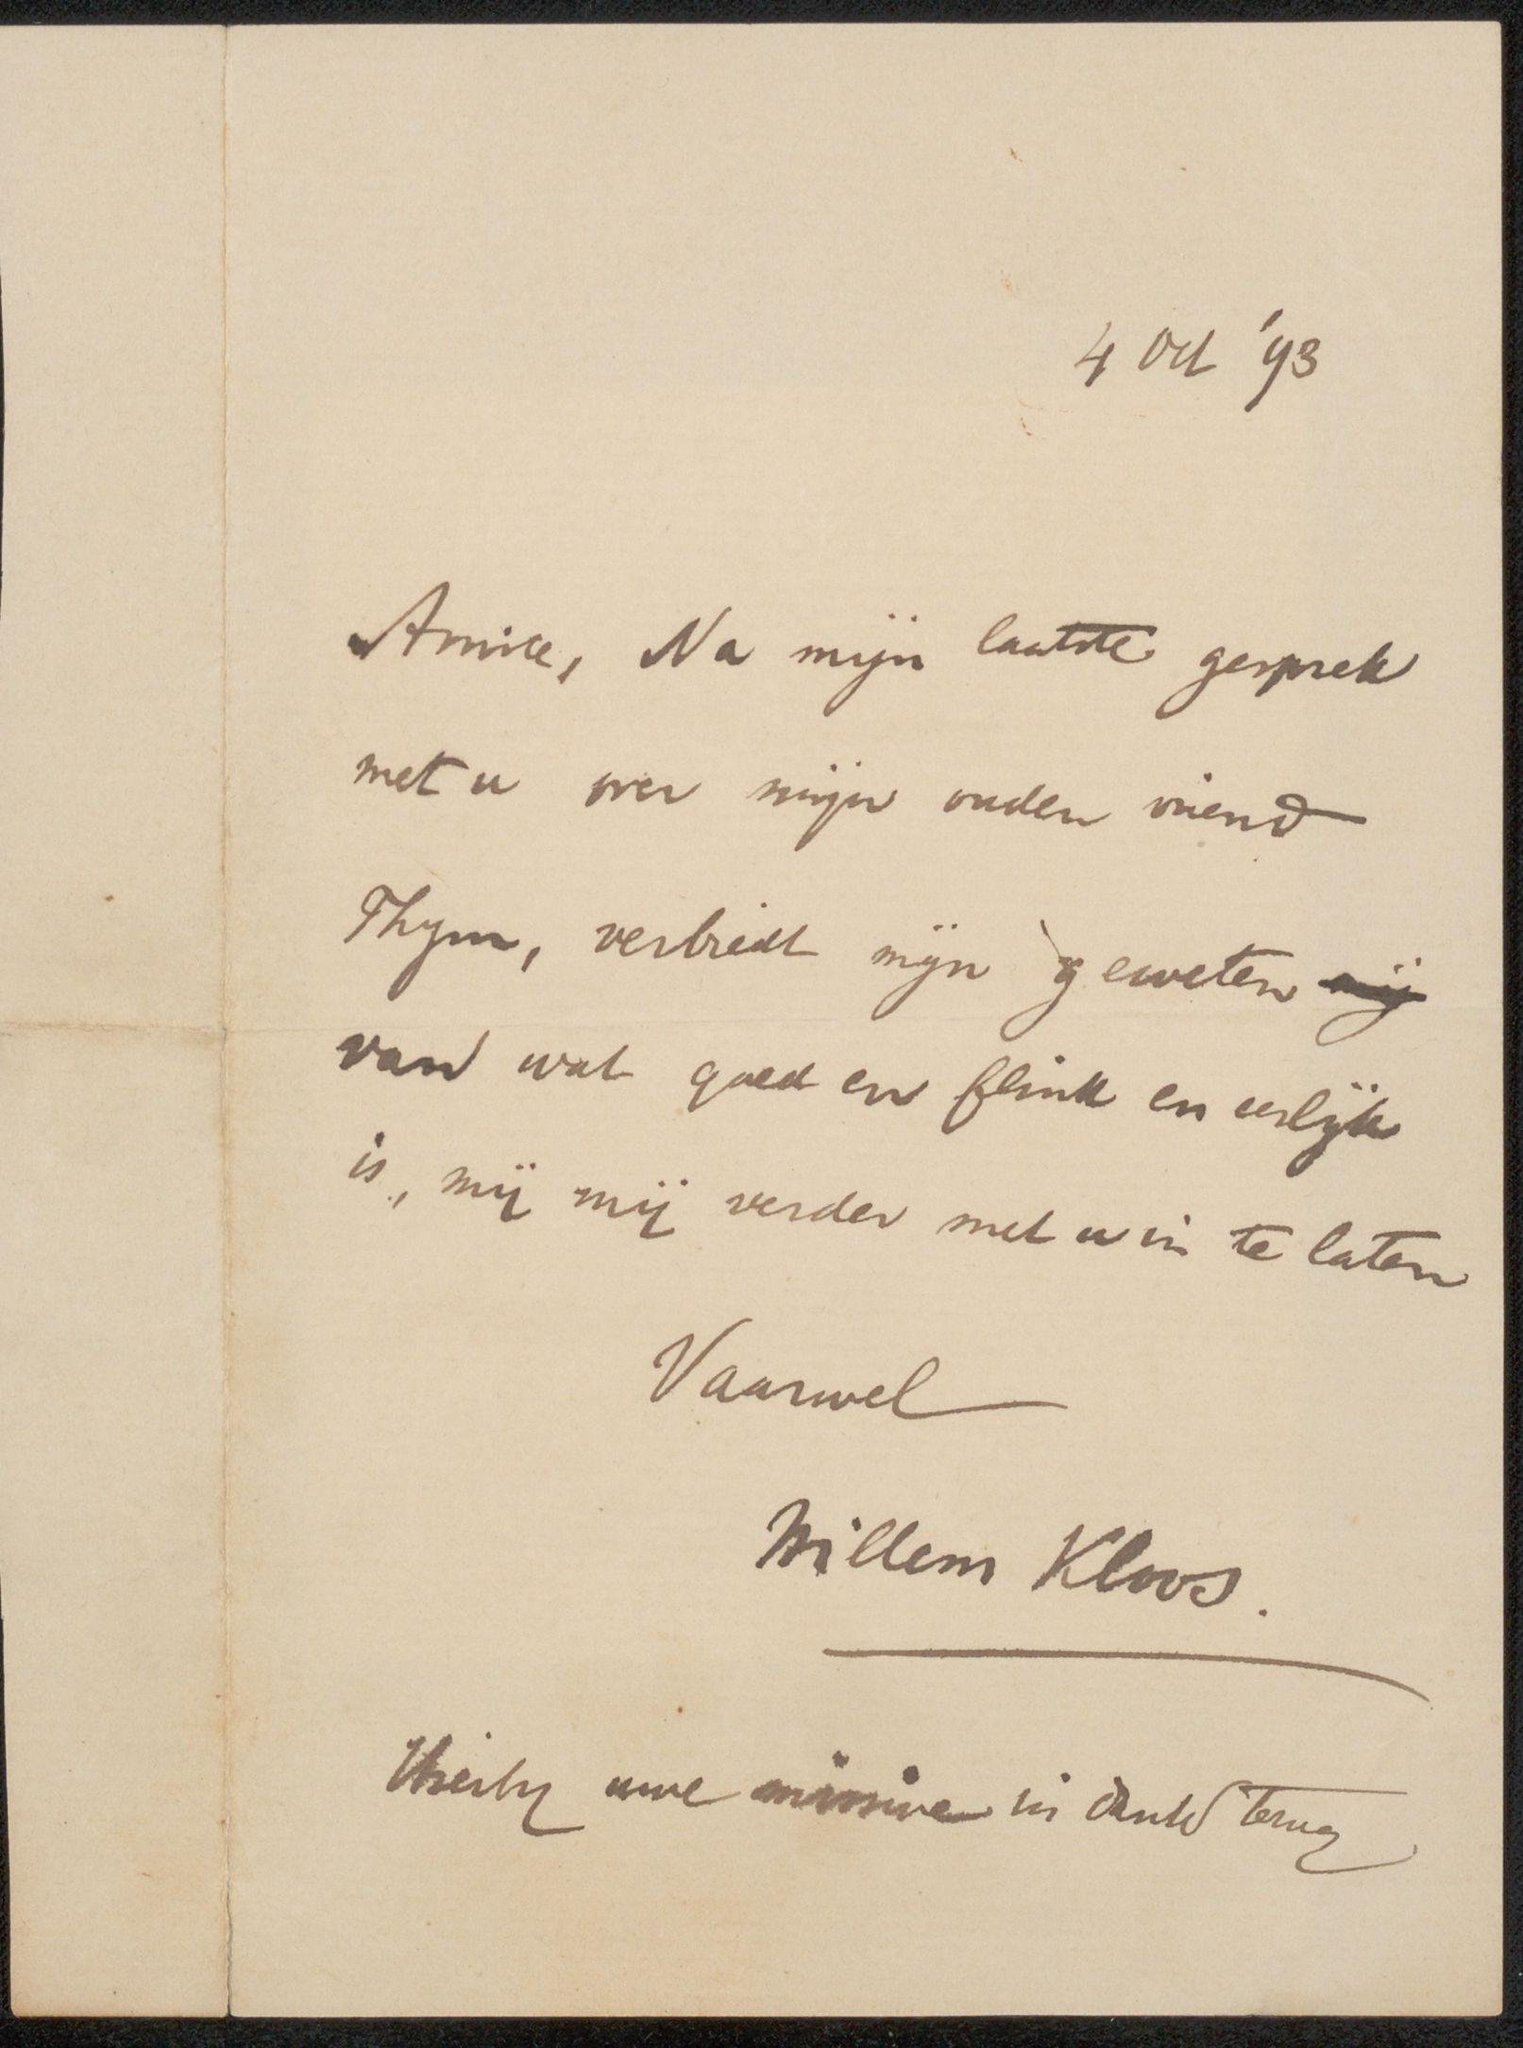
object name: letter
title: Brief aan Jan Veth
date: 1893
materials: ink, paper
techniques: pen, writing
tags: dordrecht, painter, draughtsman, designer, jan veth, publisher, josephus albertus alberdingk thijm, amsterdam, the hague, willem kloos, passions, emotions, affections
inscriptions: collector's mark: ‘RPK’